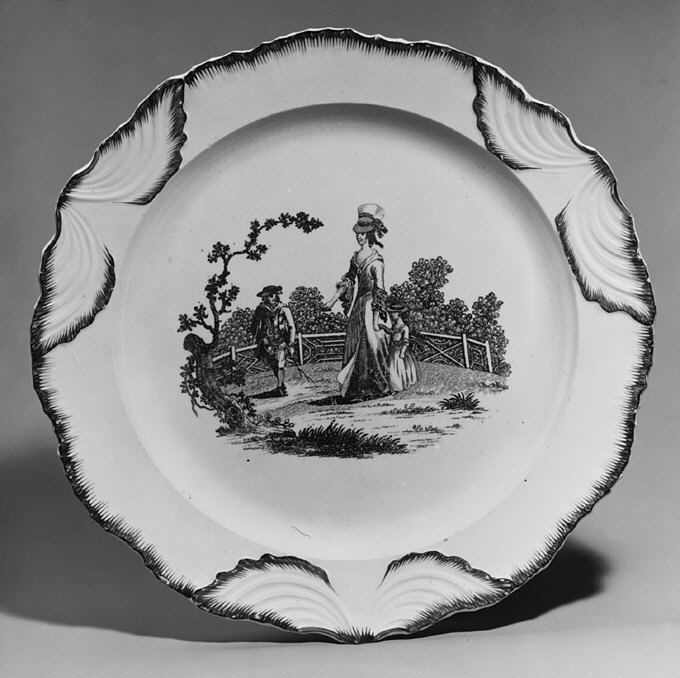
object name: plate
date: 1767-1800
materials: creamware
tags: boys,girls,women,trees